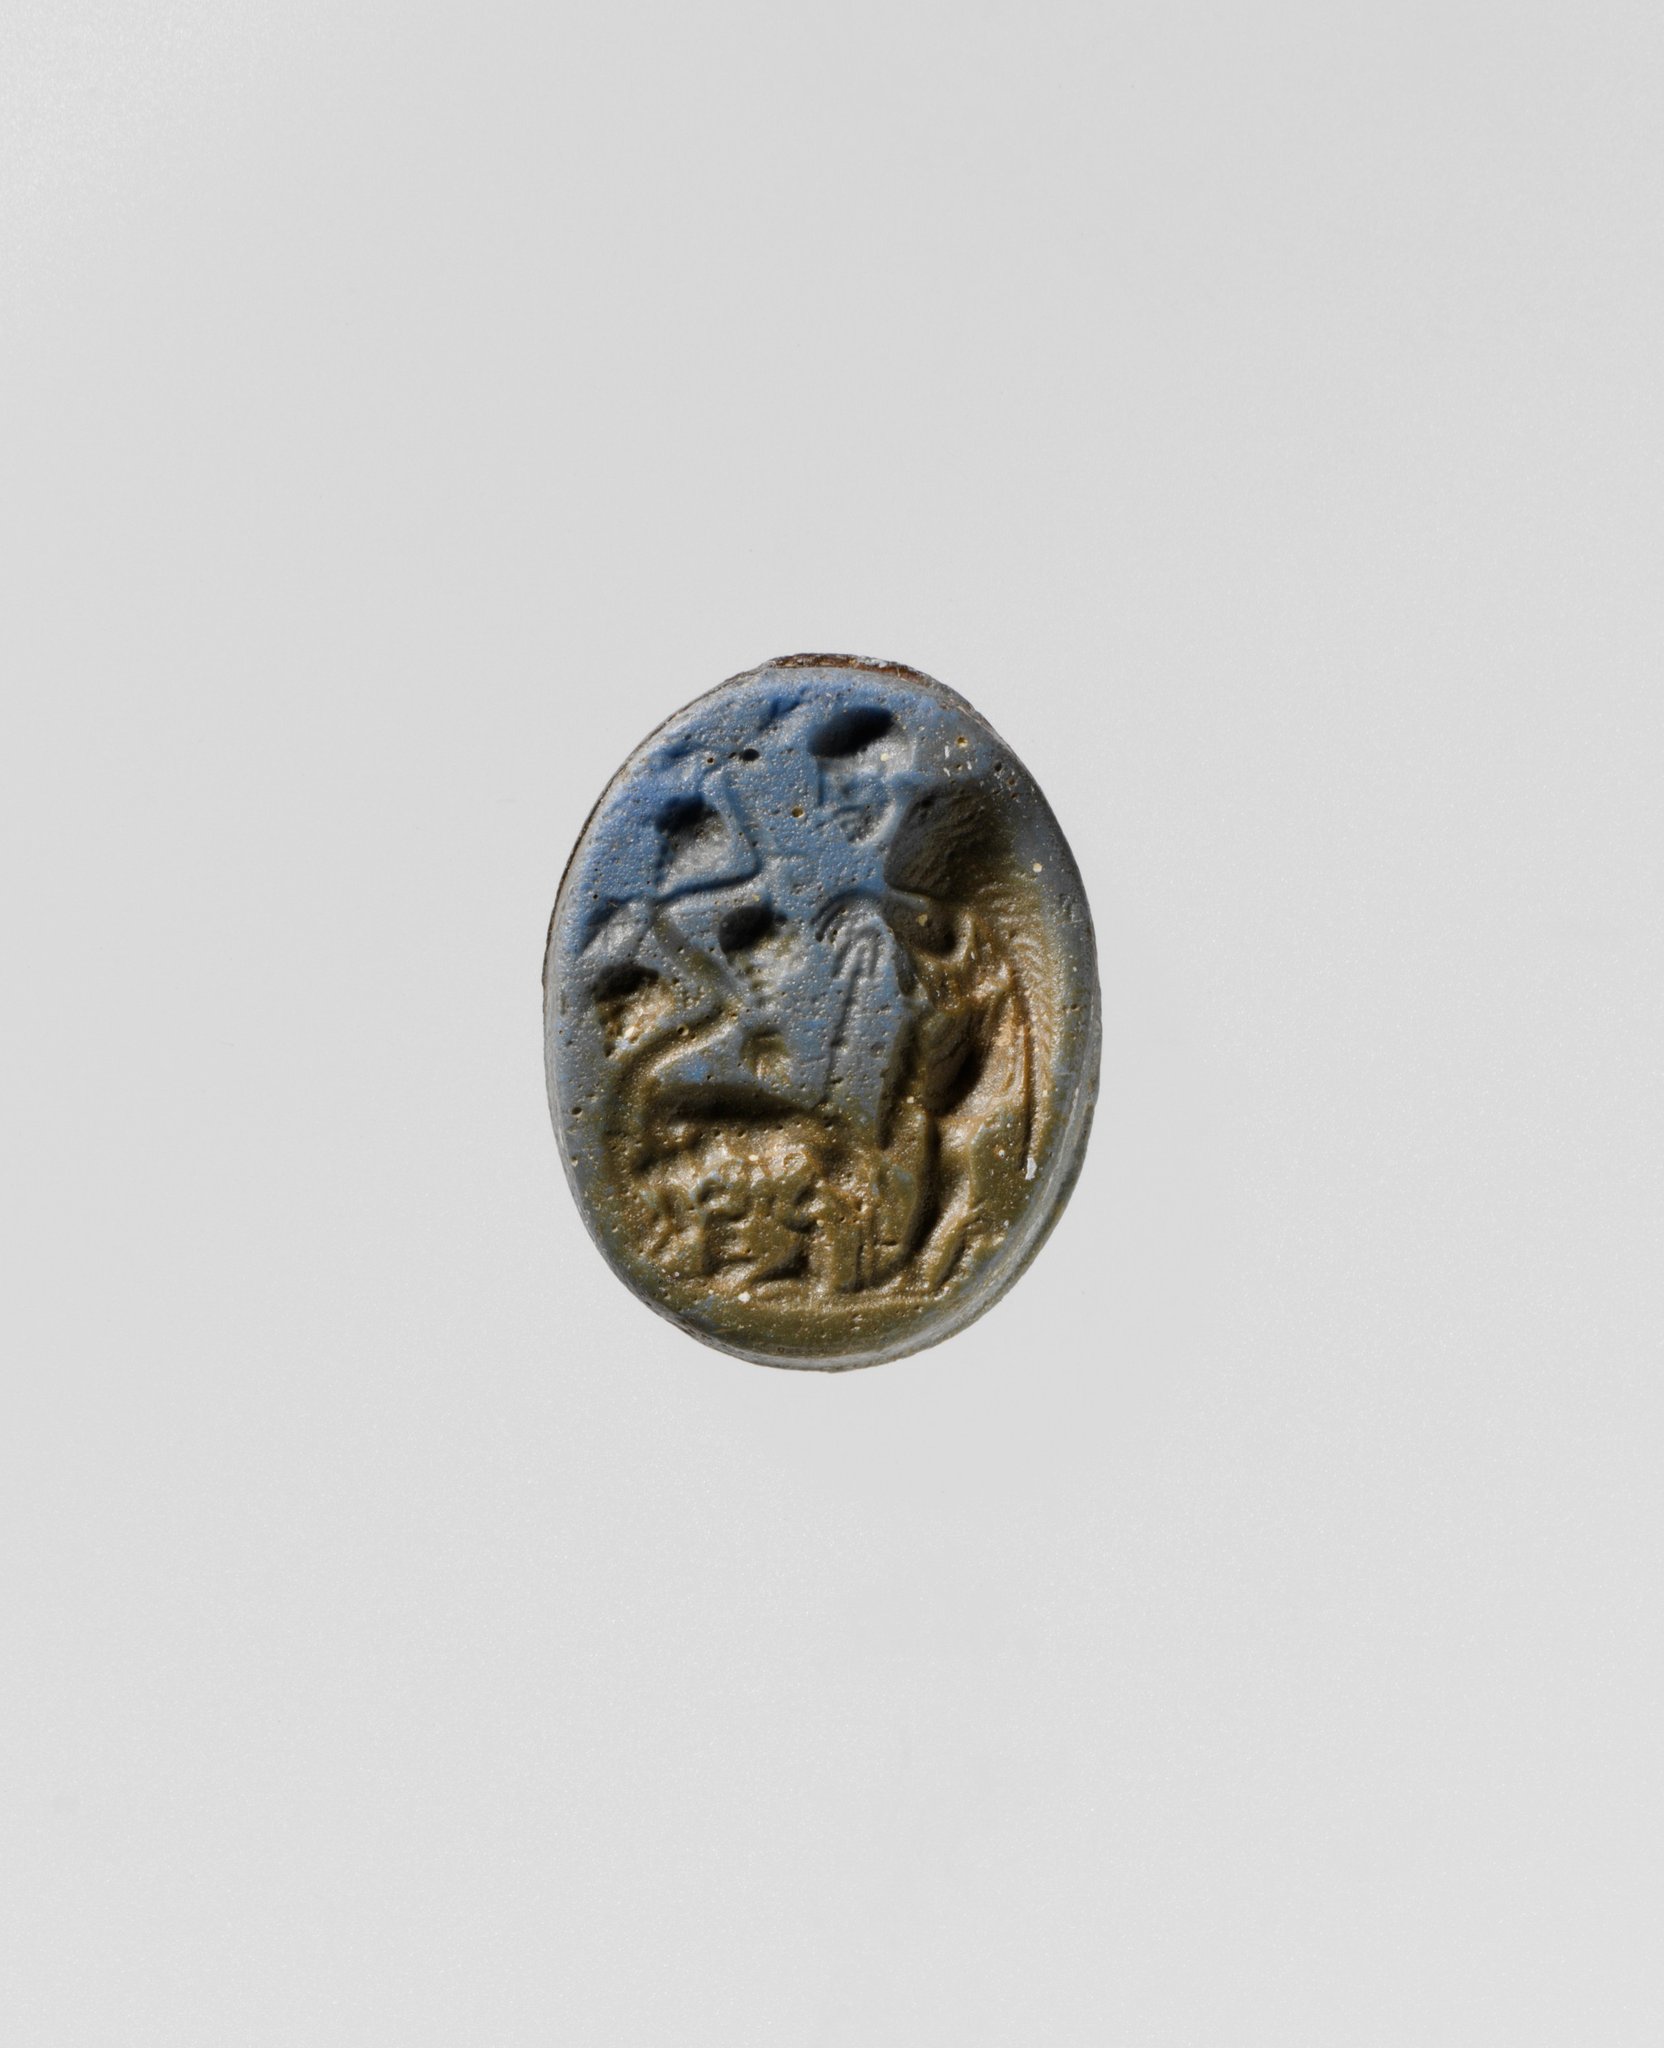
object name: intaglio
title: Opaque blue glass oval engraved gem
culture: roman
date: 100-1 BCE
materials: glass, paste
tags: women,aeneas,mars